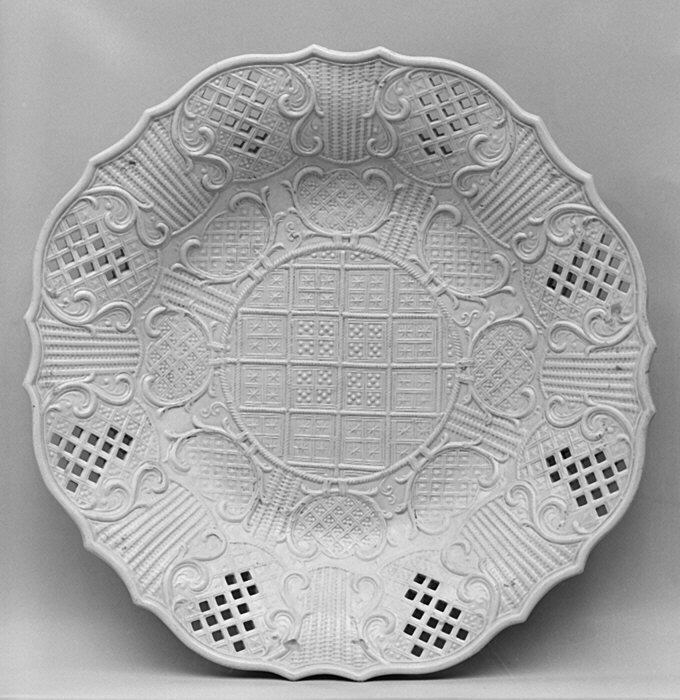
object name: plate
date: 1760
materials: stoneware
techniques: salt glaze